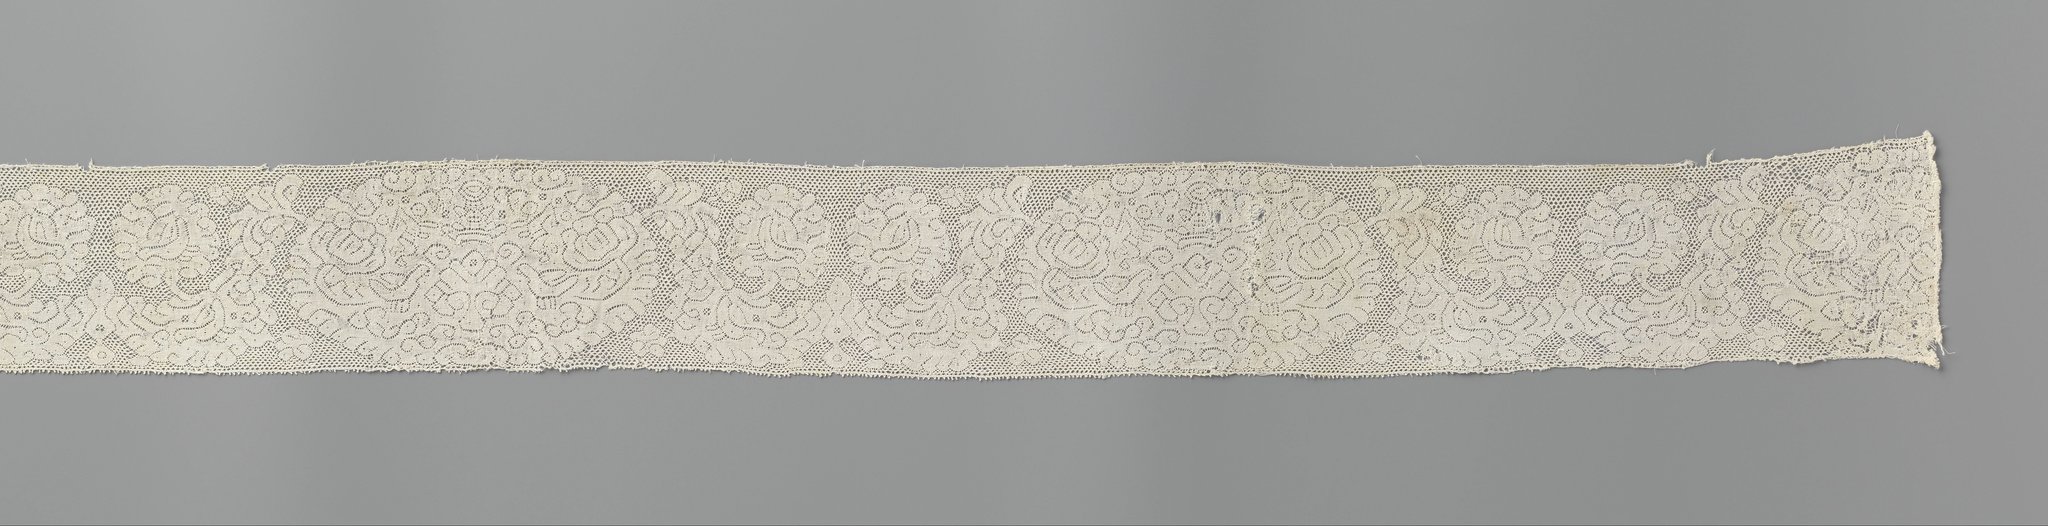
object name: strip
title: Border with Cloud and Peony Motifs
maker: Anonymous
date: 1650-1660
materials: linen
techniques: lace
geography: southern netherlands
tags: crown (symbol of sovereignty), trees, birds, angels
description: The stylized clouds and peonies look Asian and exhibit the influence of Chinese porcelain and textiles in the Netherlands. The pattern in the clouds, with two symmetrically arranged birds and two angels bearing a halo, however, seems more European. A tiny bird is also incorporated in every peony.